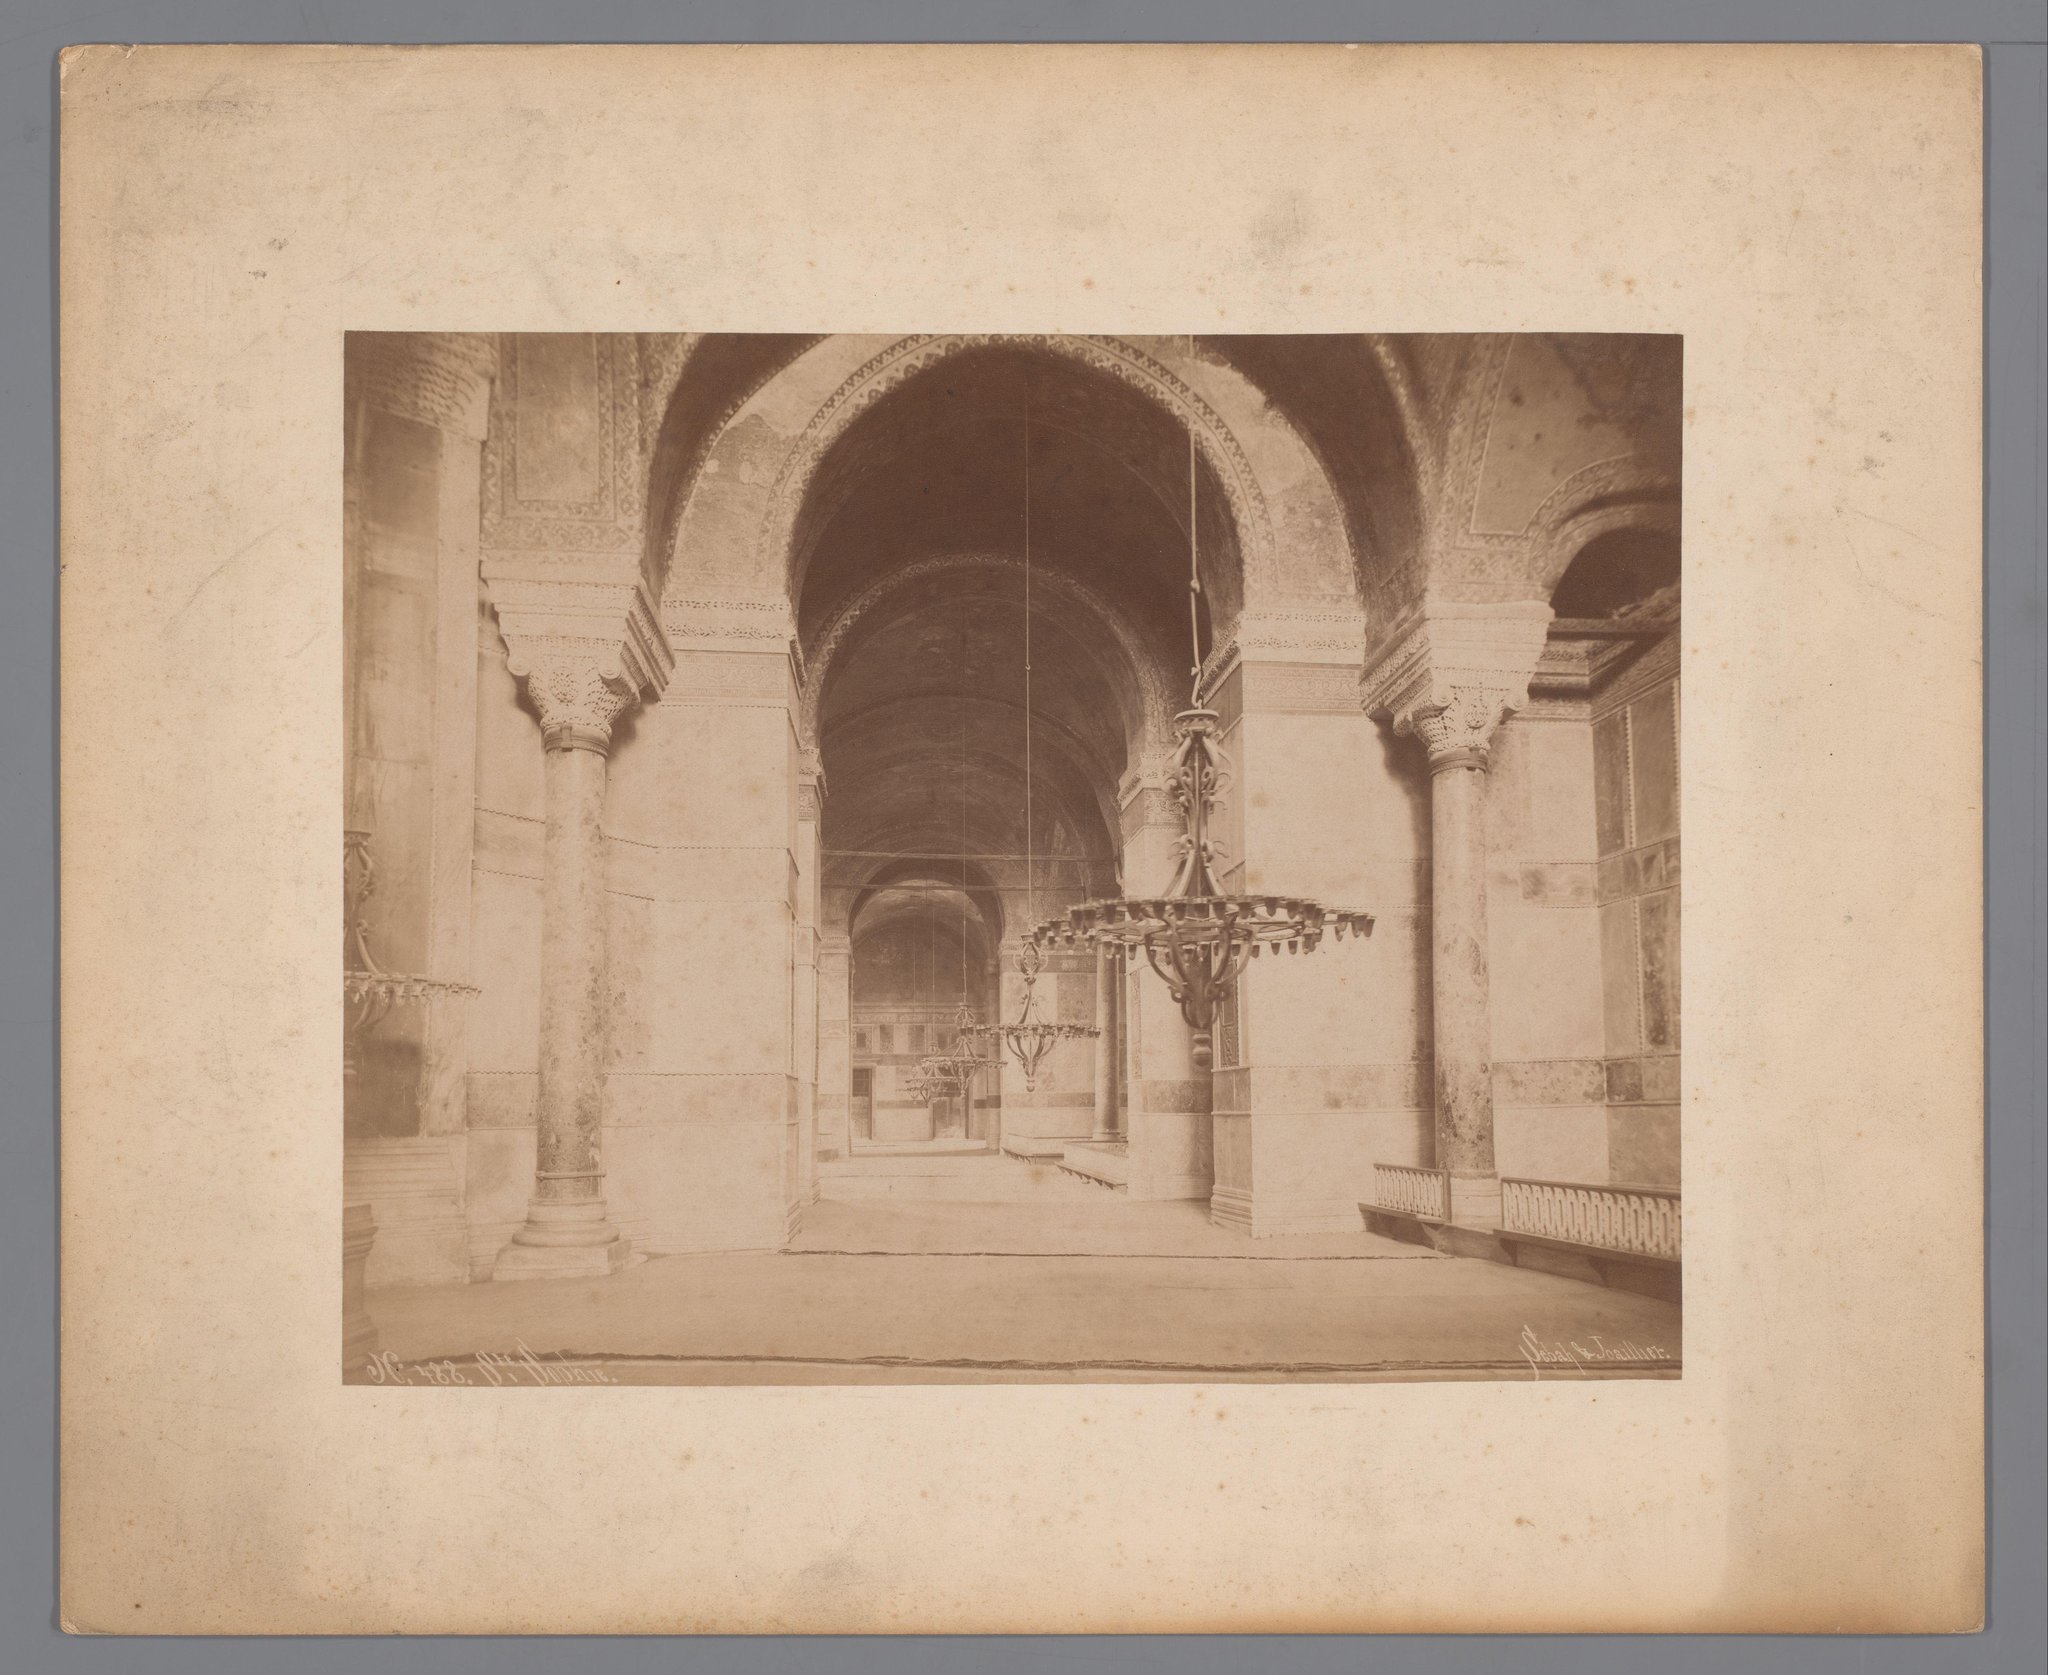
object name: photograph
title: Ste. Sophie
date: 1888-1900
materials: cardboard, paper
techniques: albumen print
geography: istanbul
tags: temple, shrine ~ islam, mohammedanism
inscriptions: number: ‘N: 488.’